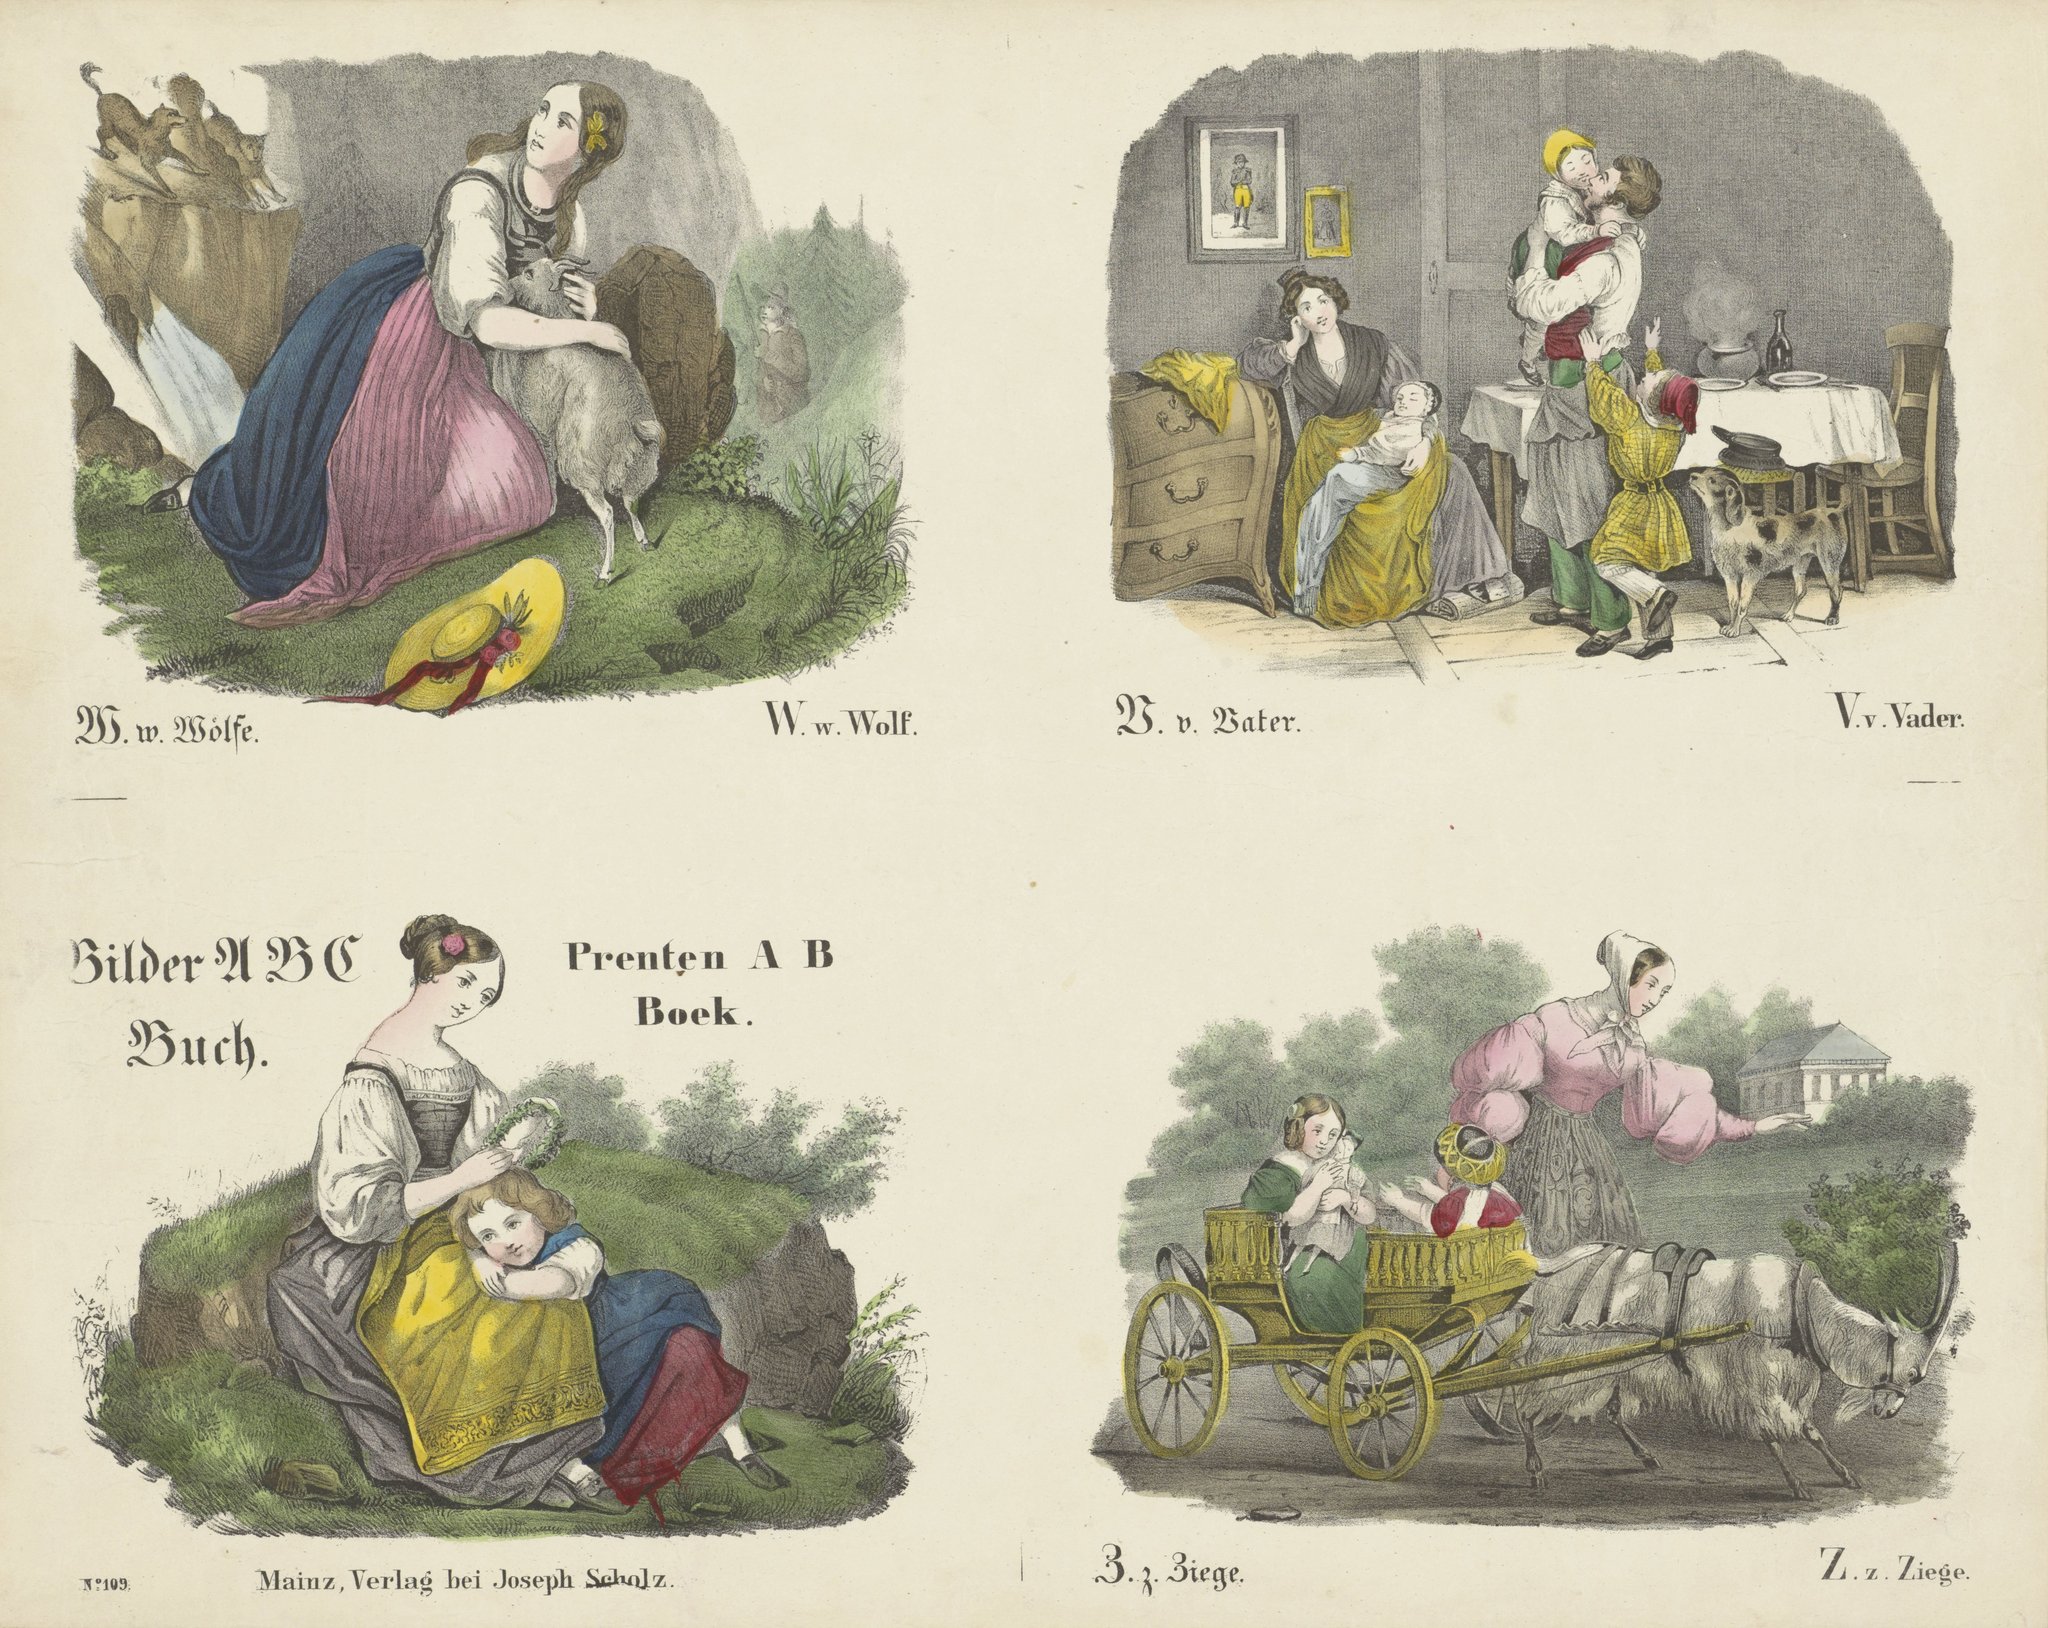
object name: popular print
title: Bilder A B C / Buch. / Prenten A B / Boek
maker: Anonymous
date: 1829-1880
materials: paper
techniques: colour, lithograph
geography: mainz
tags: letters, alphabet, script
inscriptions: collector's mark: Lugt 2760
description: Blad met 4 voorstellingen om uit te knippen en samen tot boekje over het alfabet te binden. Drie verbeeldingen van de letters W (Wolf), V (Vader) en Z (Ziege). Linksonder de titelprent met een moeder die haar dochter een krans op het hoofd doet. Onder elke afbeelding een onderschrift in het Duits en in het Nederlands. Genummerd linksonder: No. 109.